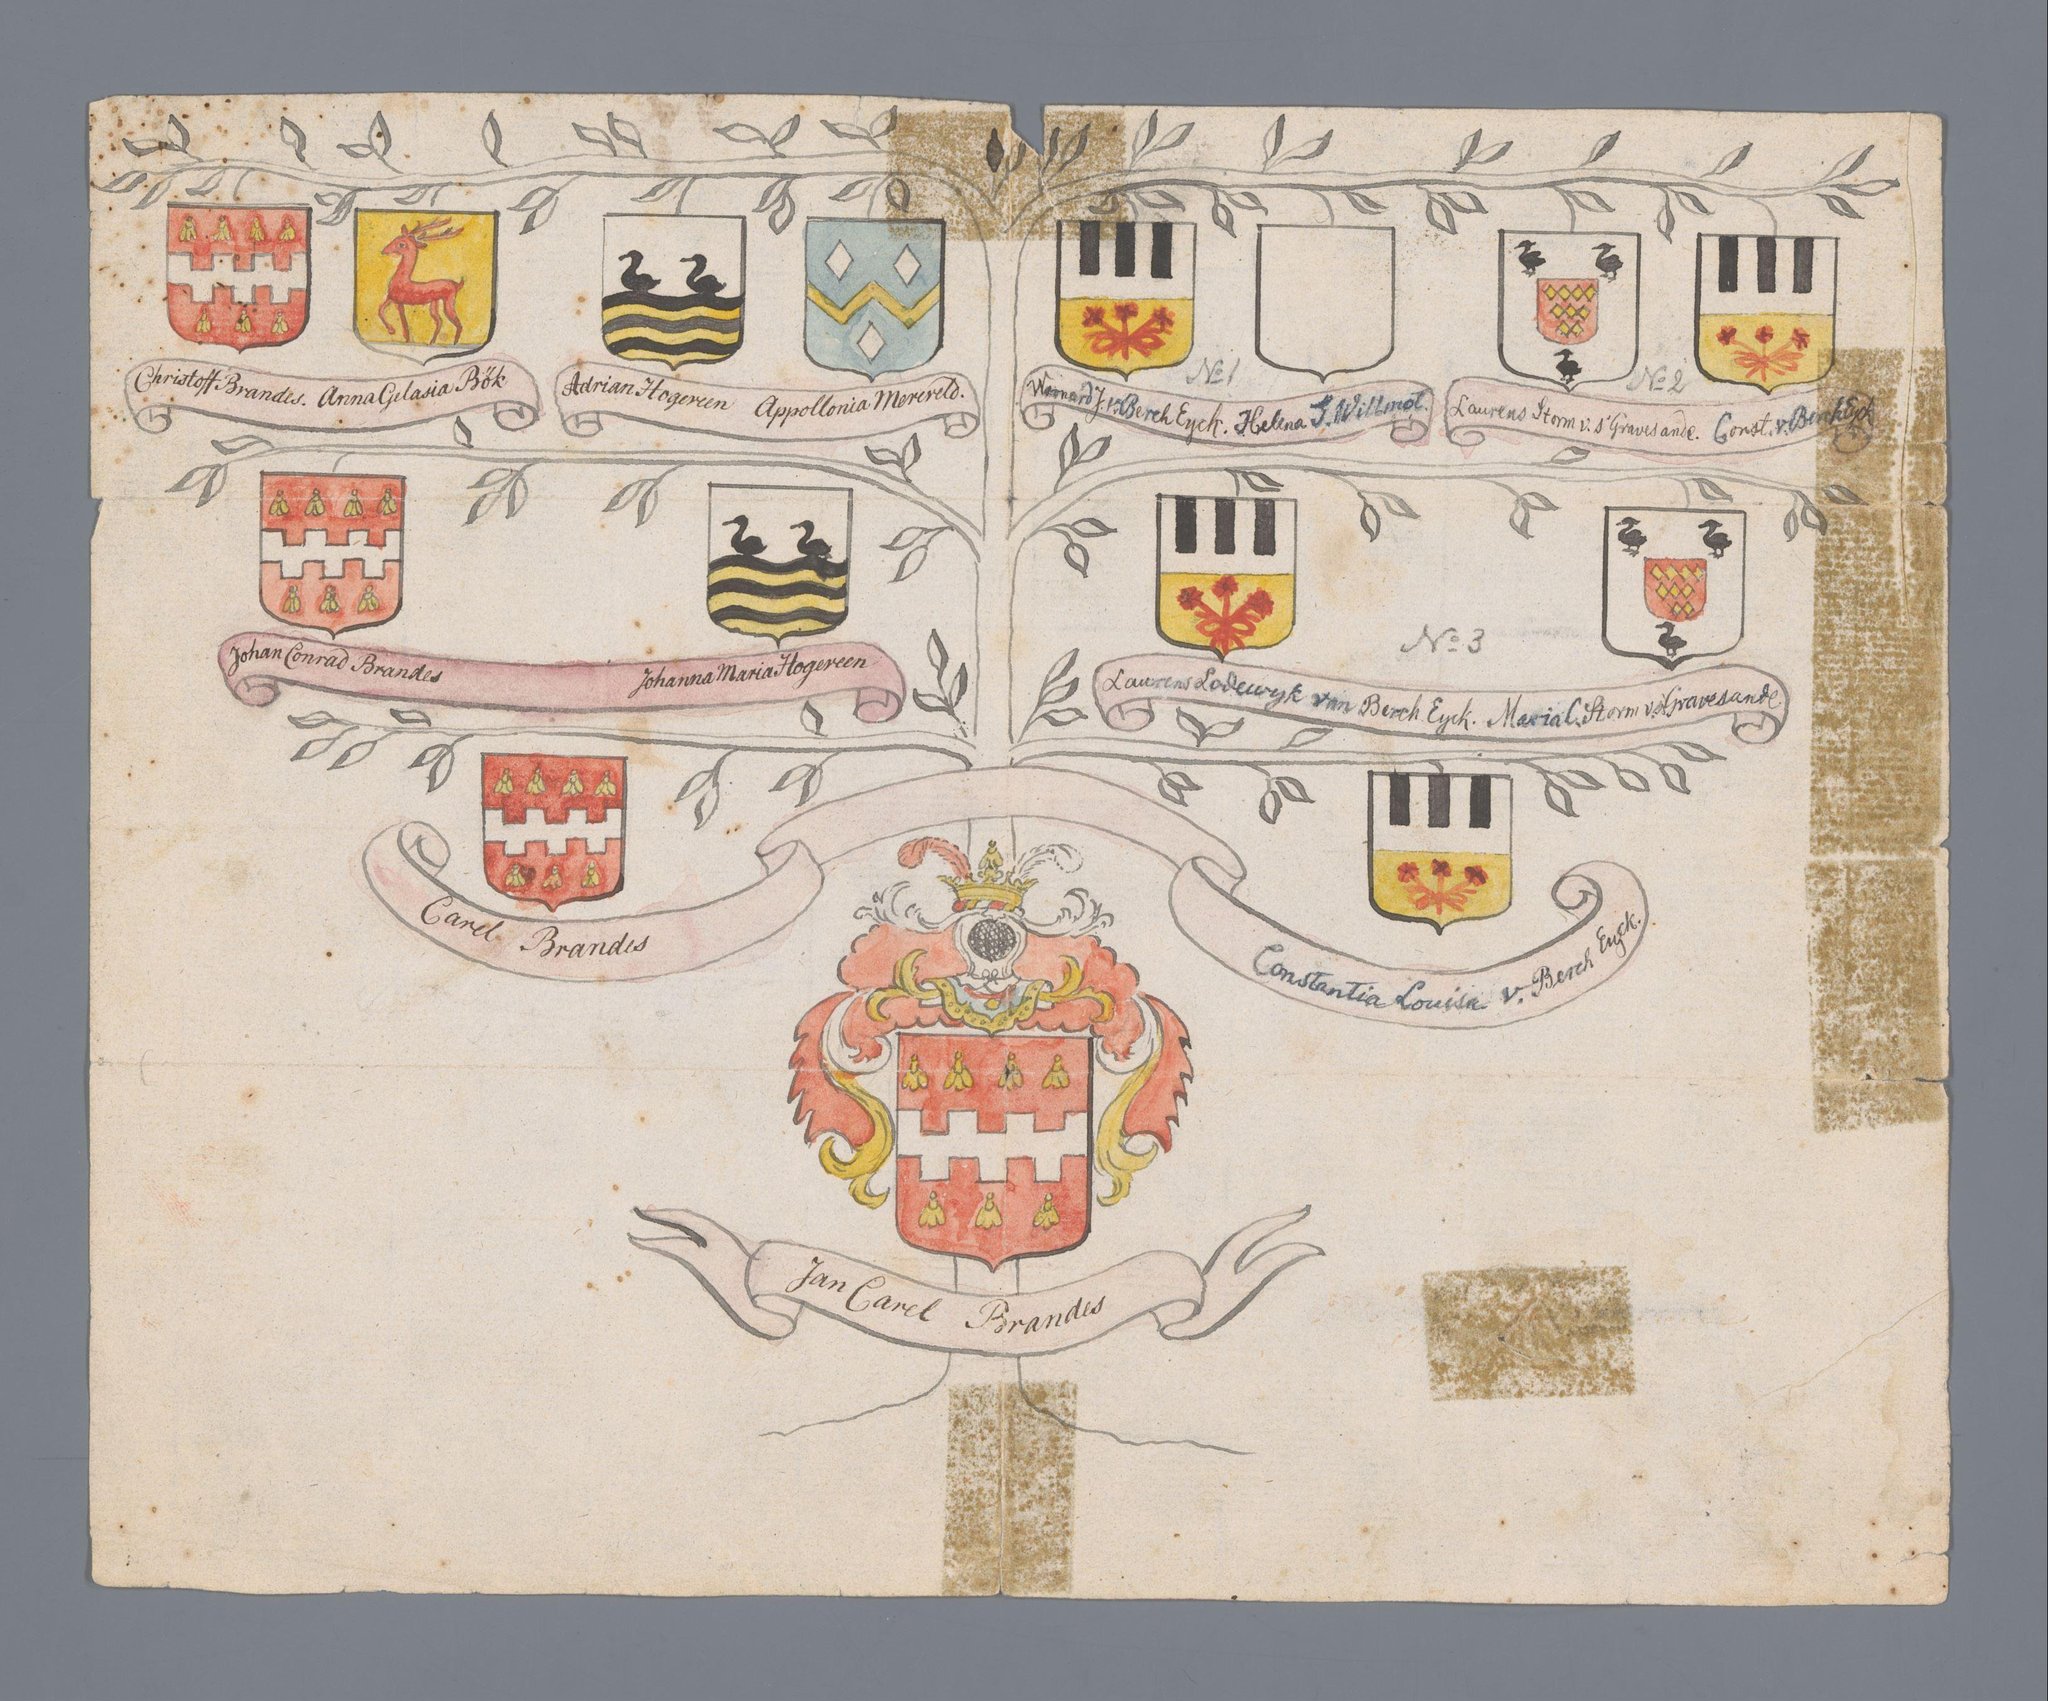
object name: drawing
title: Stamboom van de familie Brandes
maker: jan brandes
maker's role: draughtsman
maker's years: 1743-1808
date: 1760-1790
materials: ink, paper, watercolor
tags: family lineage, pedigree, genealogical tree or table